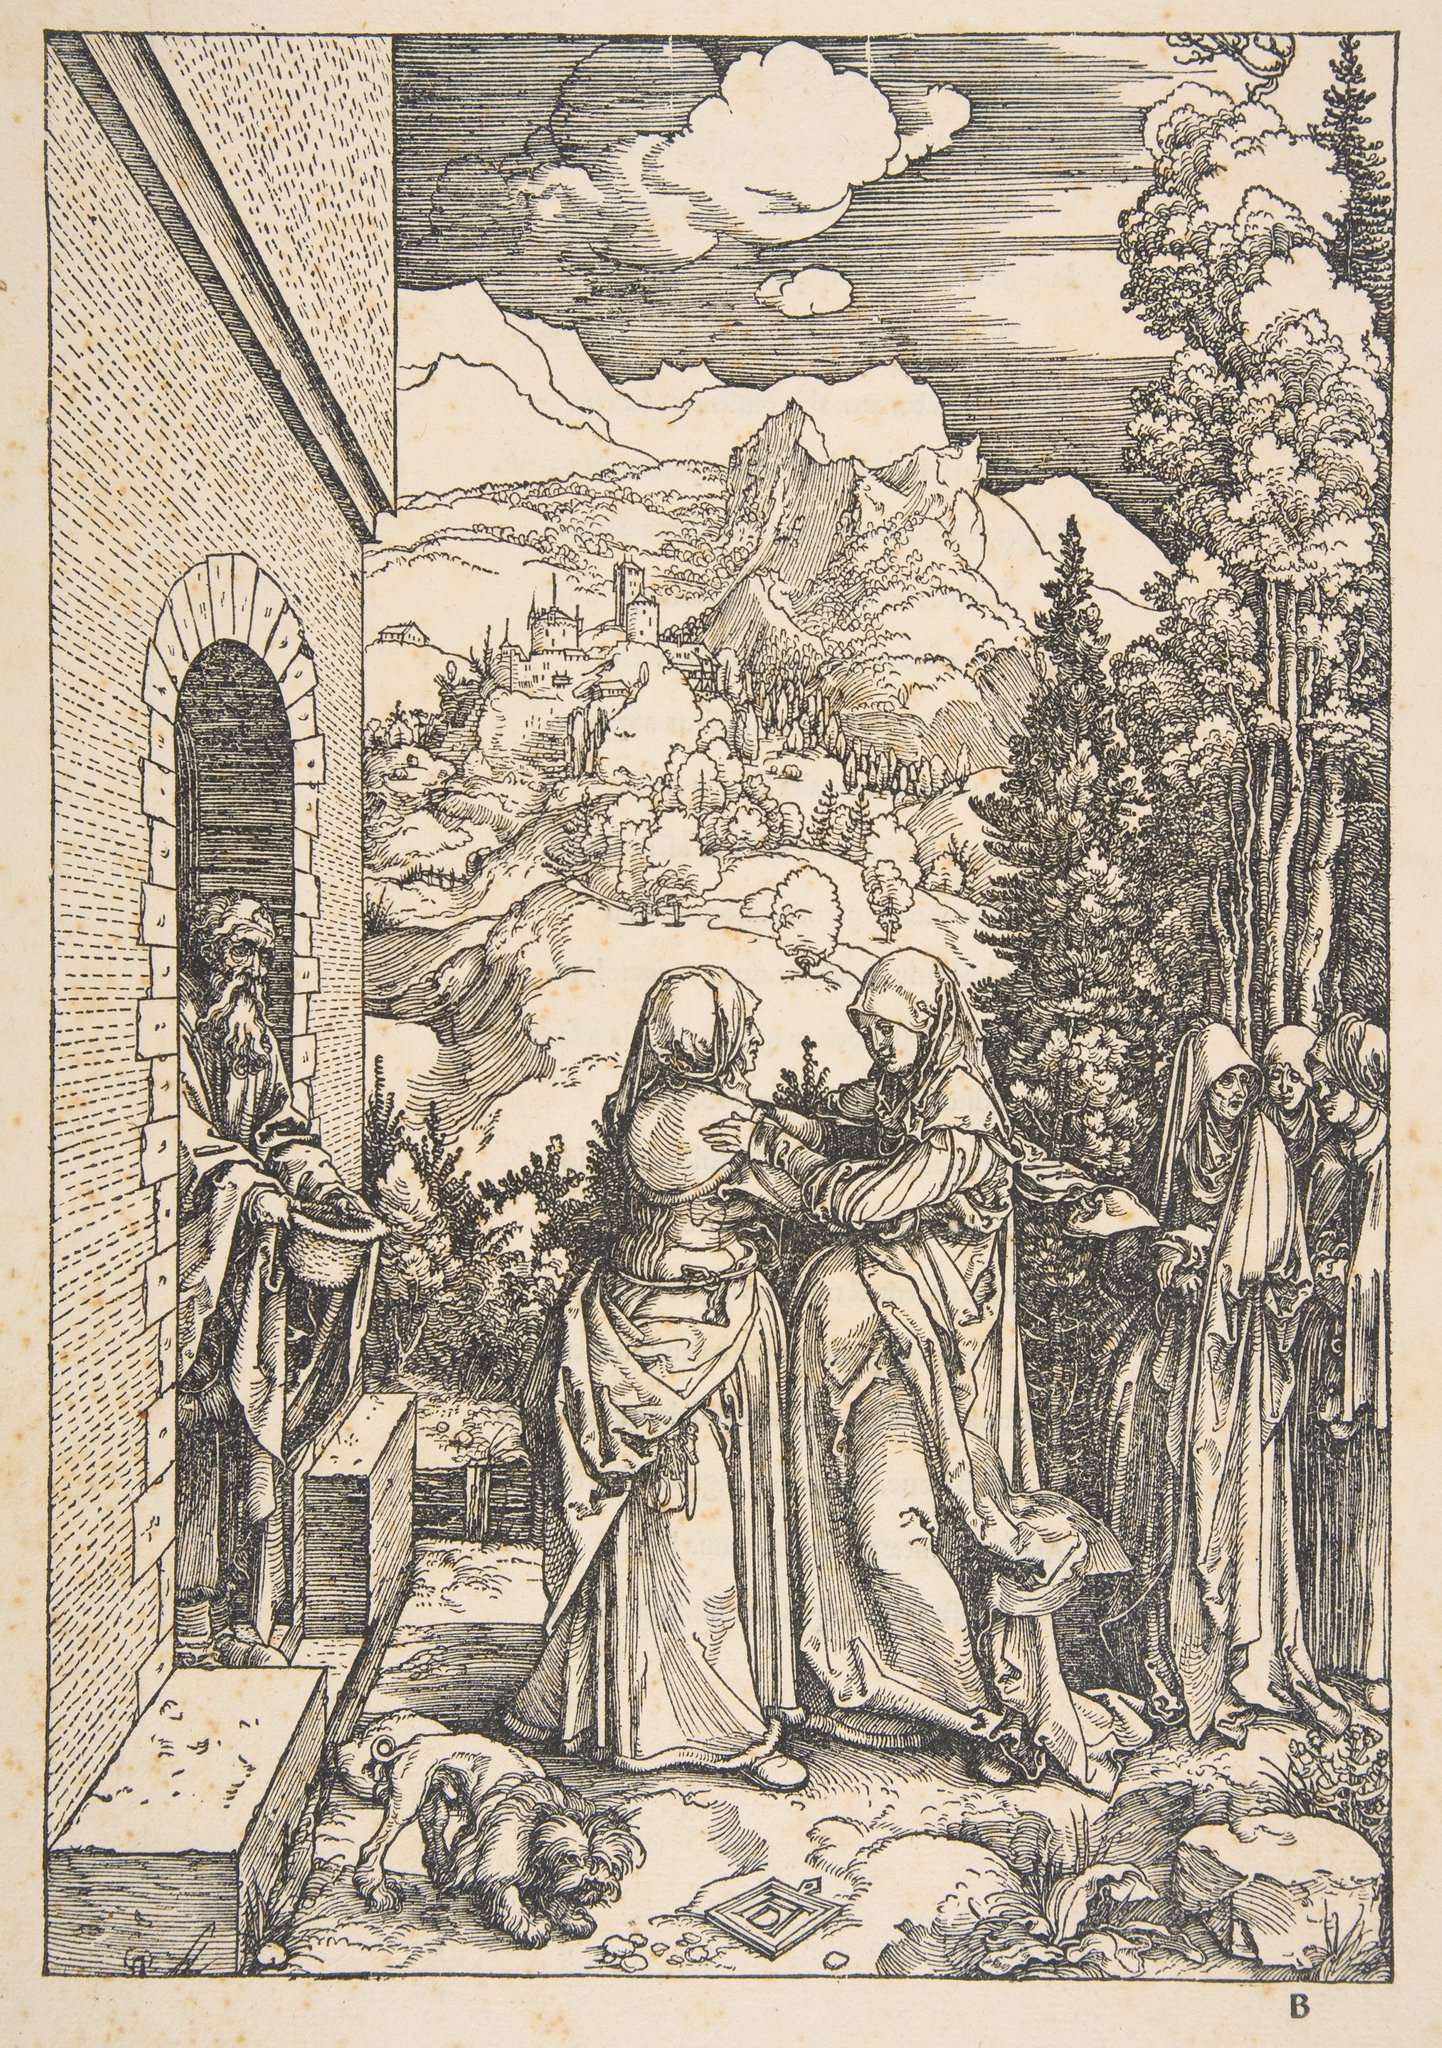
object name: print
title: The Visitation, from "The Life of the Virgin"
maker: albrecht dürer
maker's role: artist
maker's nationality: german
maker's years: 1471-1528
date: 1503-1504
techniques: woodcut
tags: virgin mary